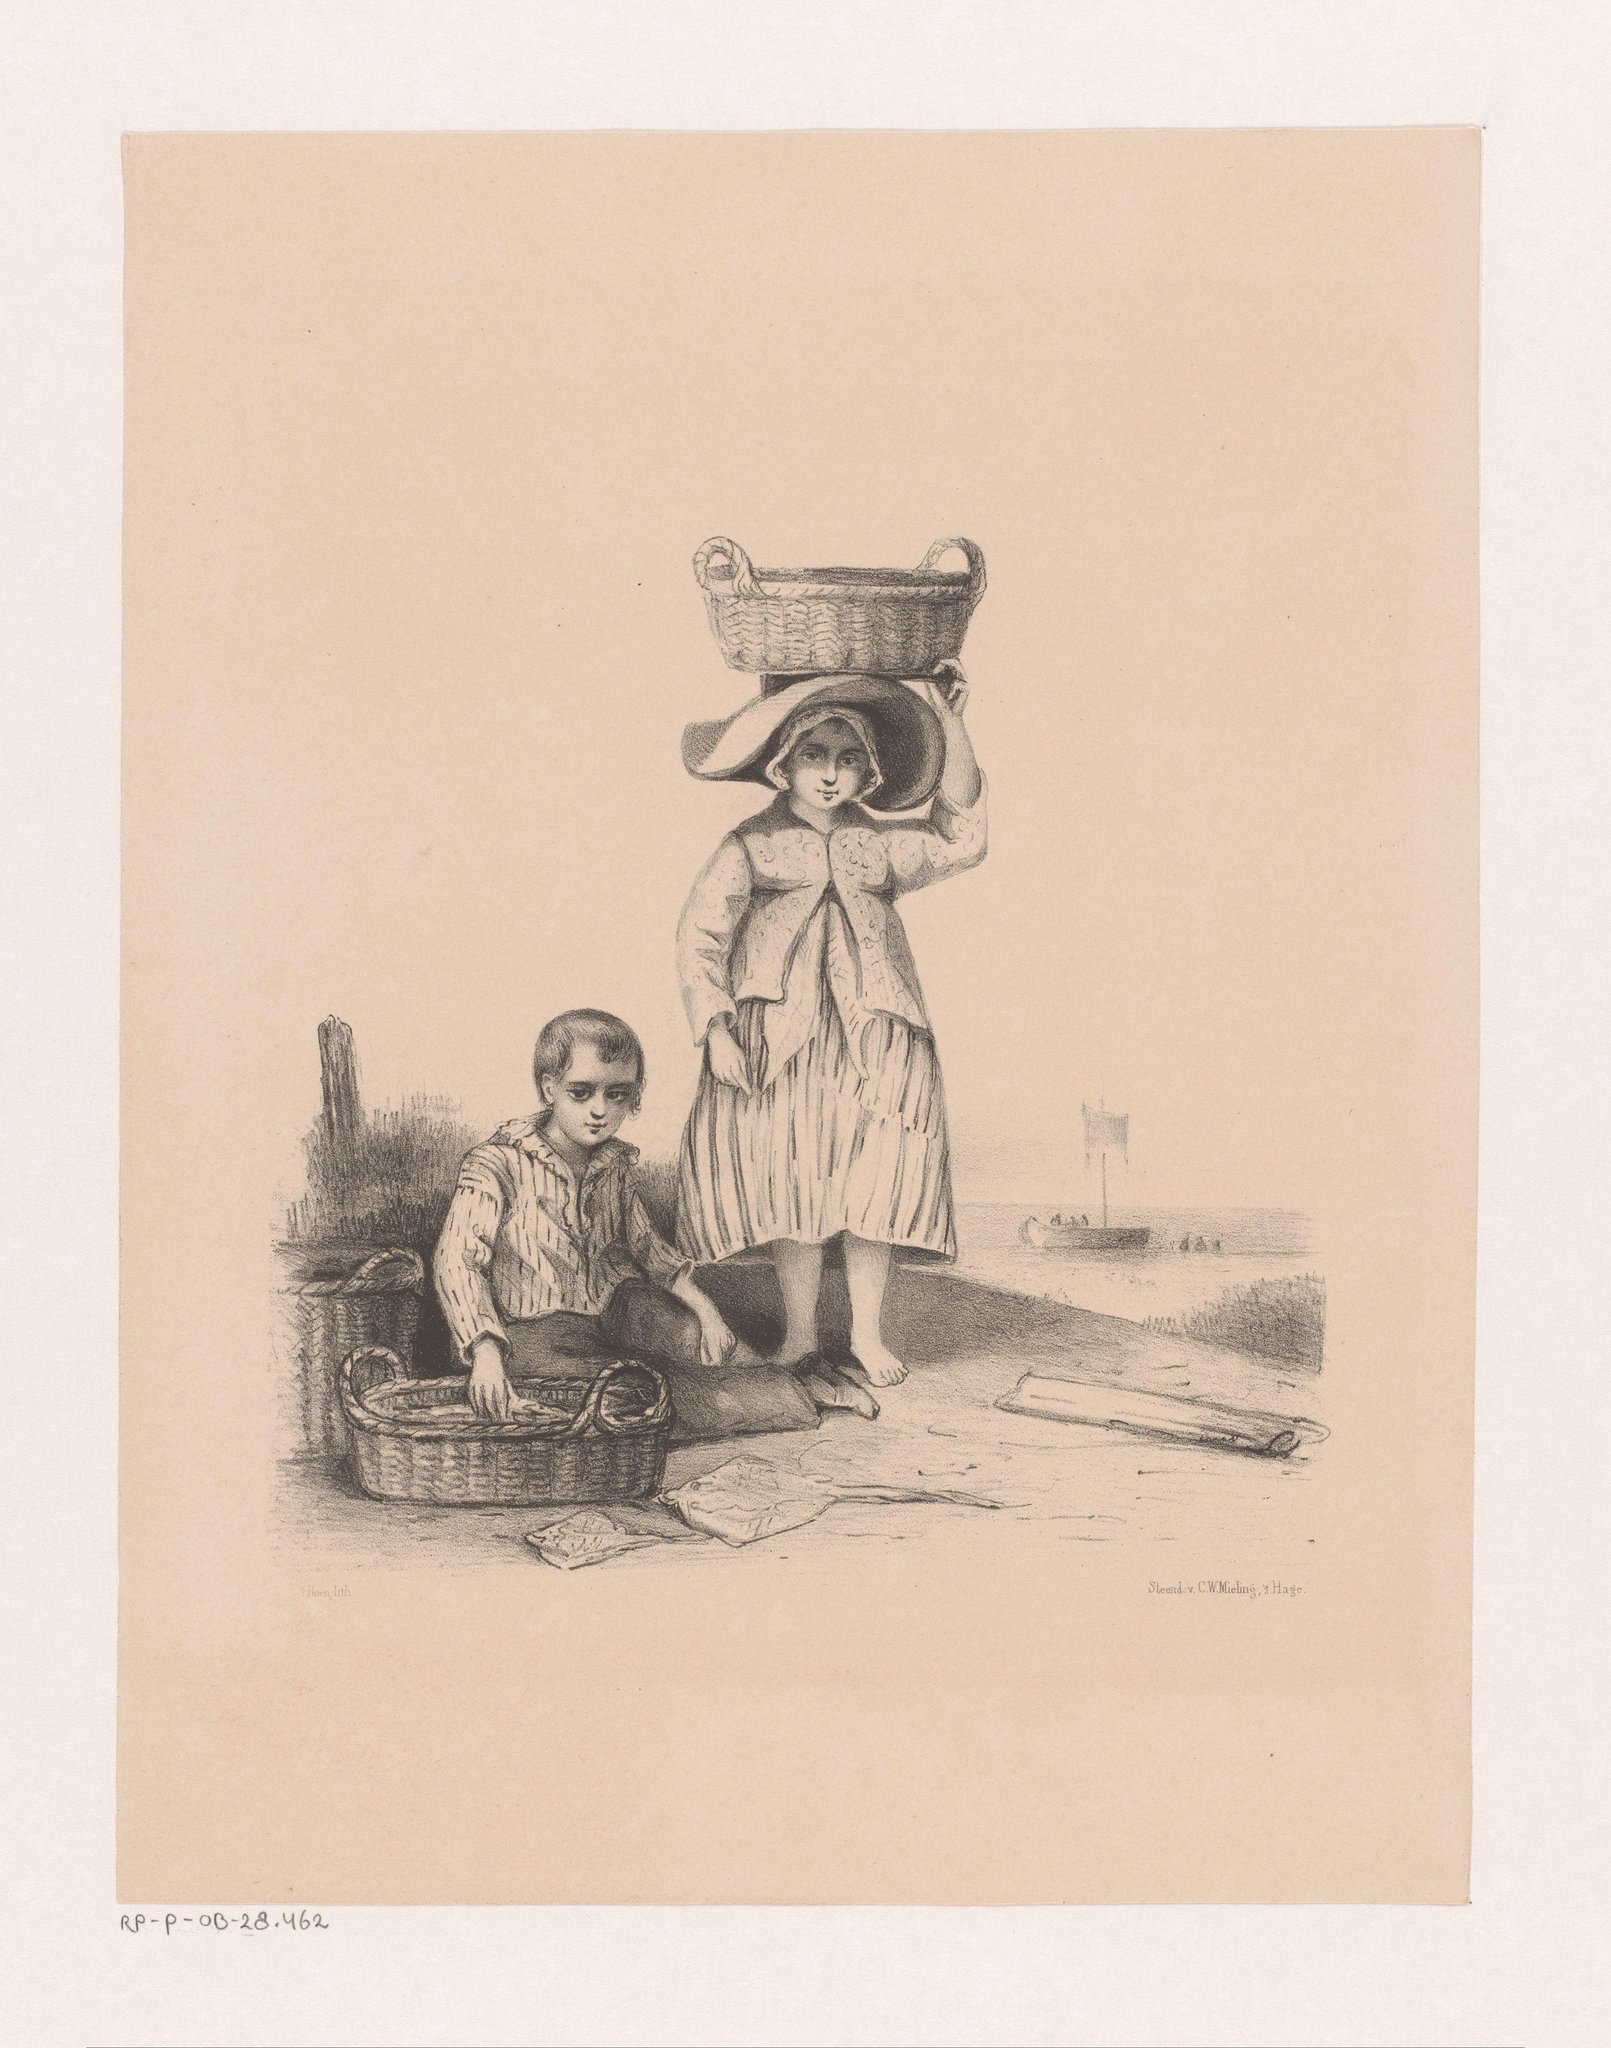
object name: print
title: Meisje en jongen op een kade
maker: cornelis petrus t hoen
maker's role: print maker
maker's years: 1814-1880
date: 1847-1863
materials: paper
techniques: lithograph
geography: the hague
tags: boy (child between toddler and youth) (+ sitting), girl (child between toddler and youth) (+ standing), container made of plant material other than wood: basket, pier, quay, wharf, carrying something on the head or on the shoulders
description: Het meisje draagt een hoed met daarop een rieten mand. De jongen zit naast een mand op de grond.